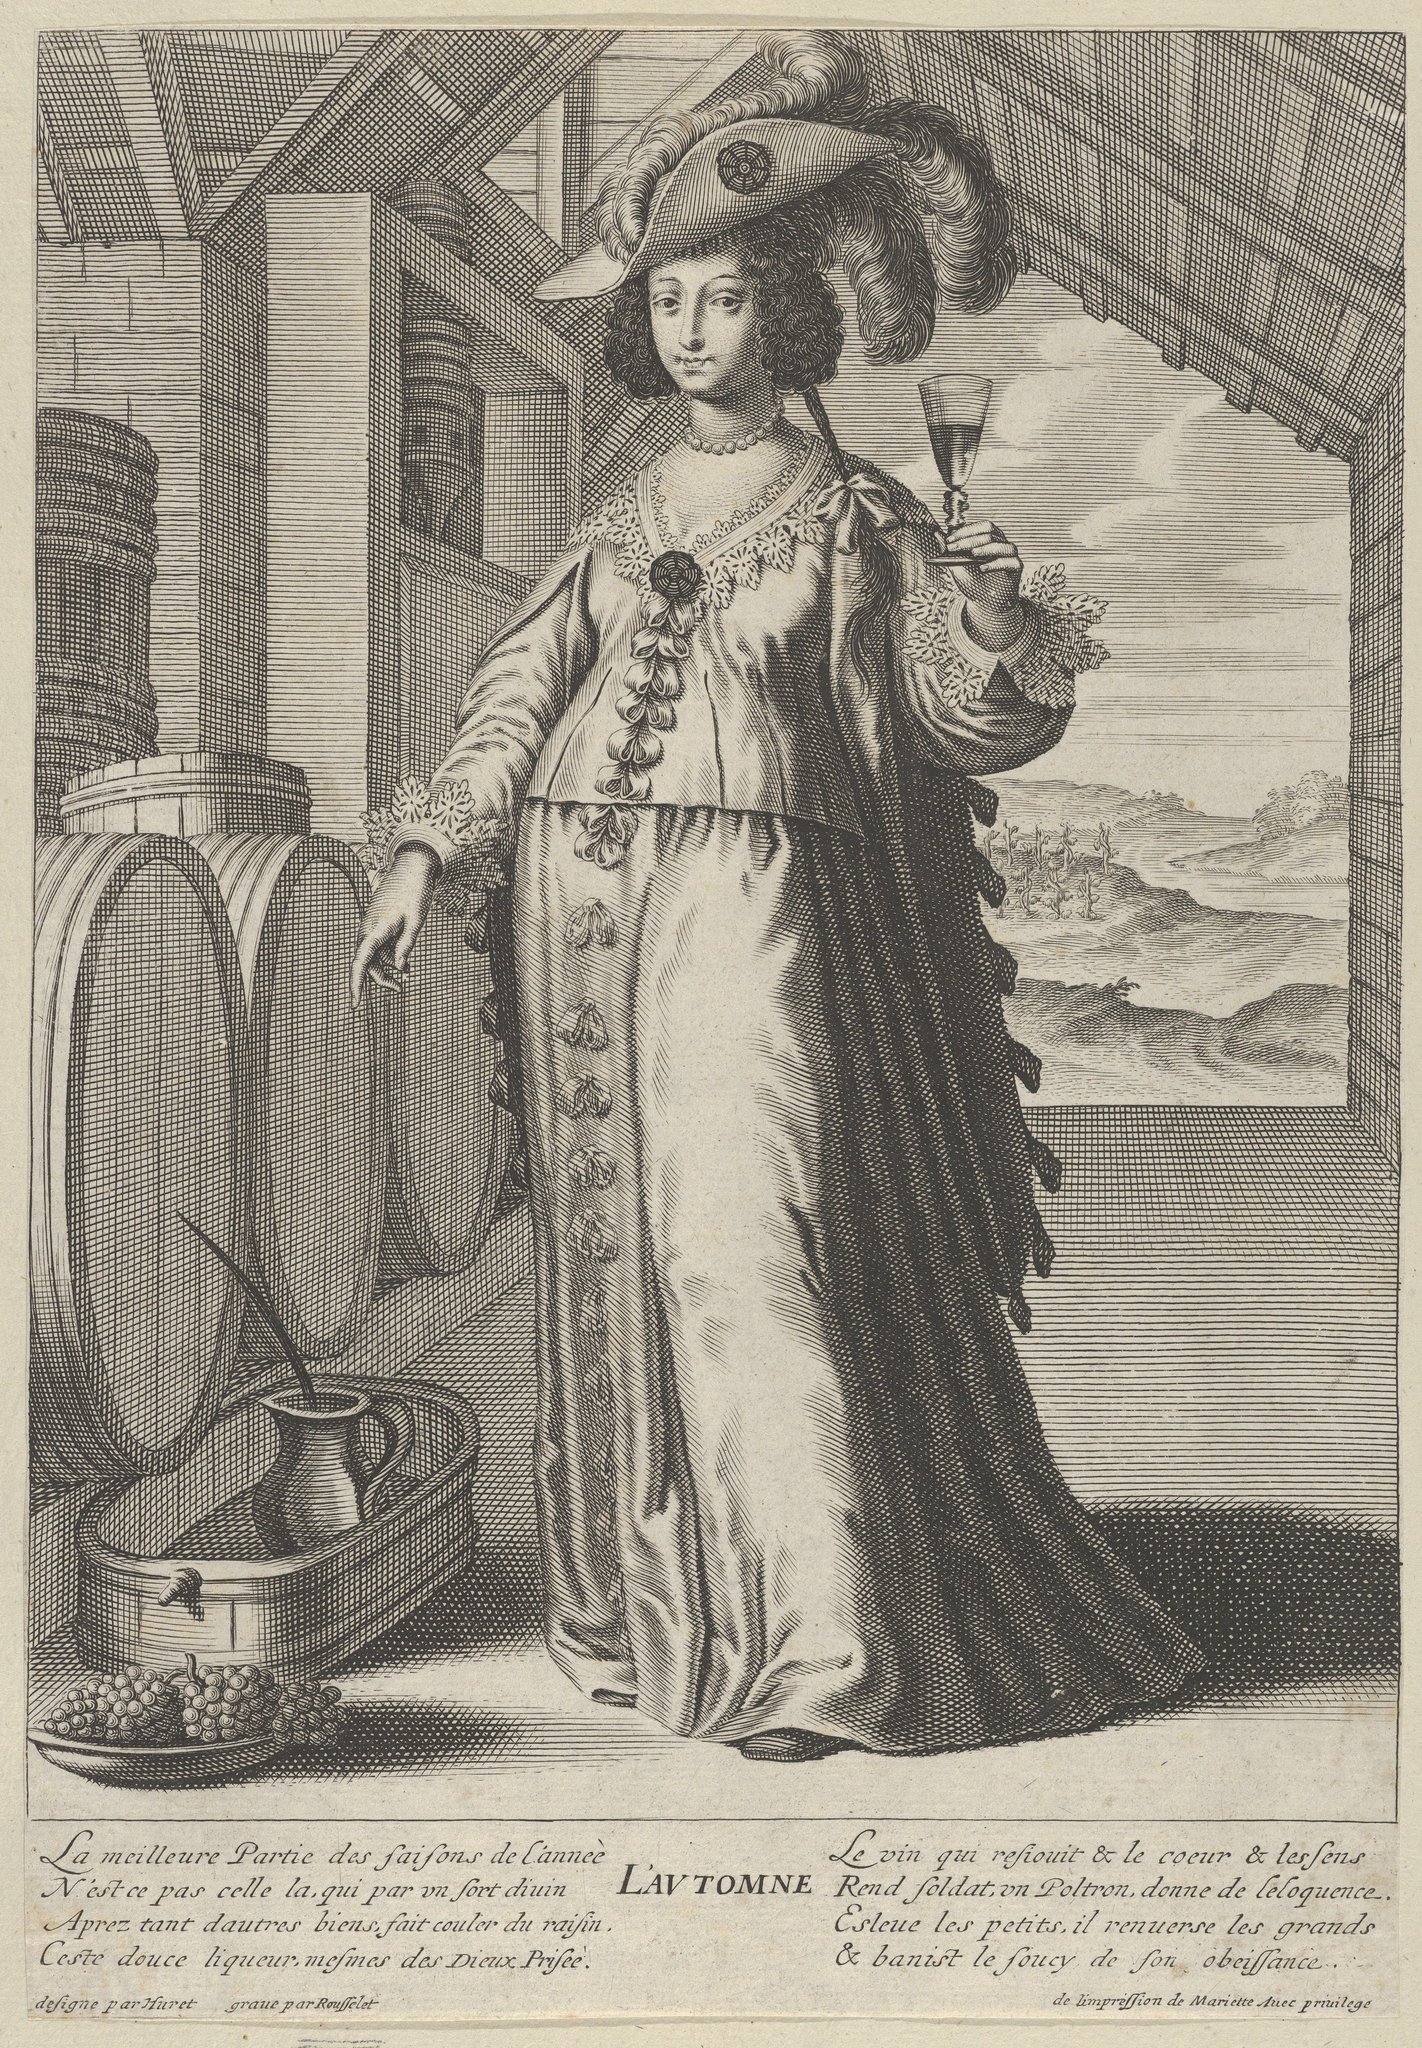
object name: print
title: Autumn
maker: gilles rousselet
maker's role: artist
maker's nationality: french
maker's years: 1614-1686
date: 1601-1700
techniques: engraving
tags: wine,women,barrels